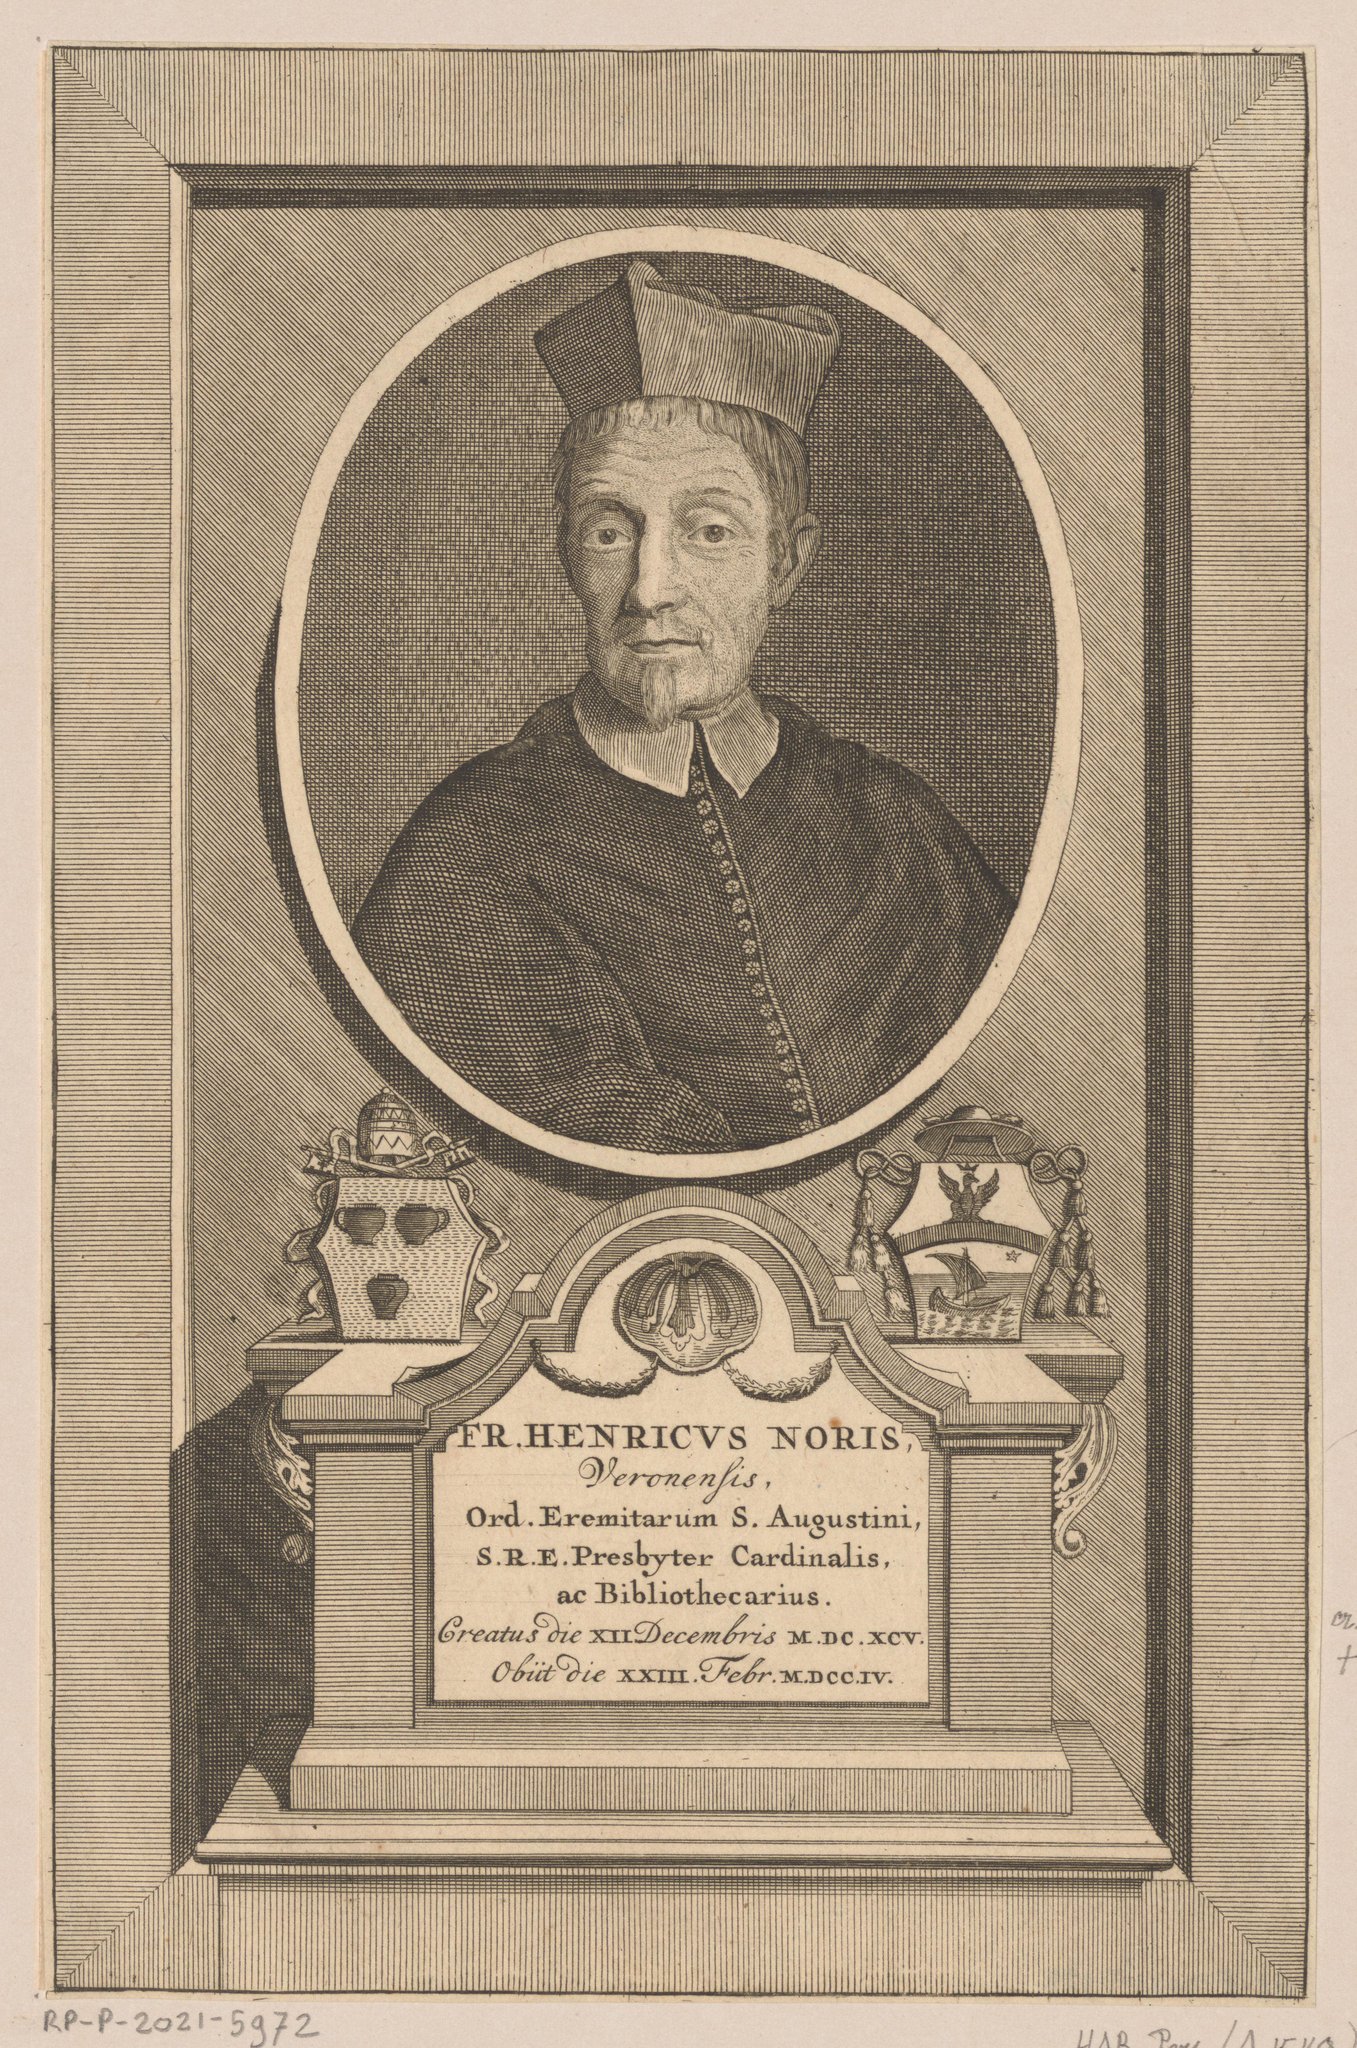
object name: print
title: Portret van Enrico Noris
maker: Anonymous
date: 1704-1750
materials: paper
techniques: engraving, etching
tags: rome, cardinal, historical persons